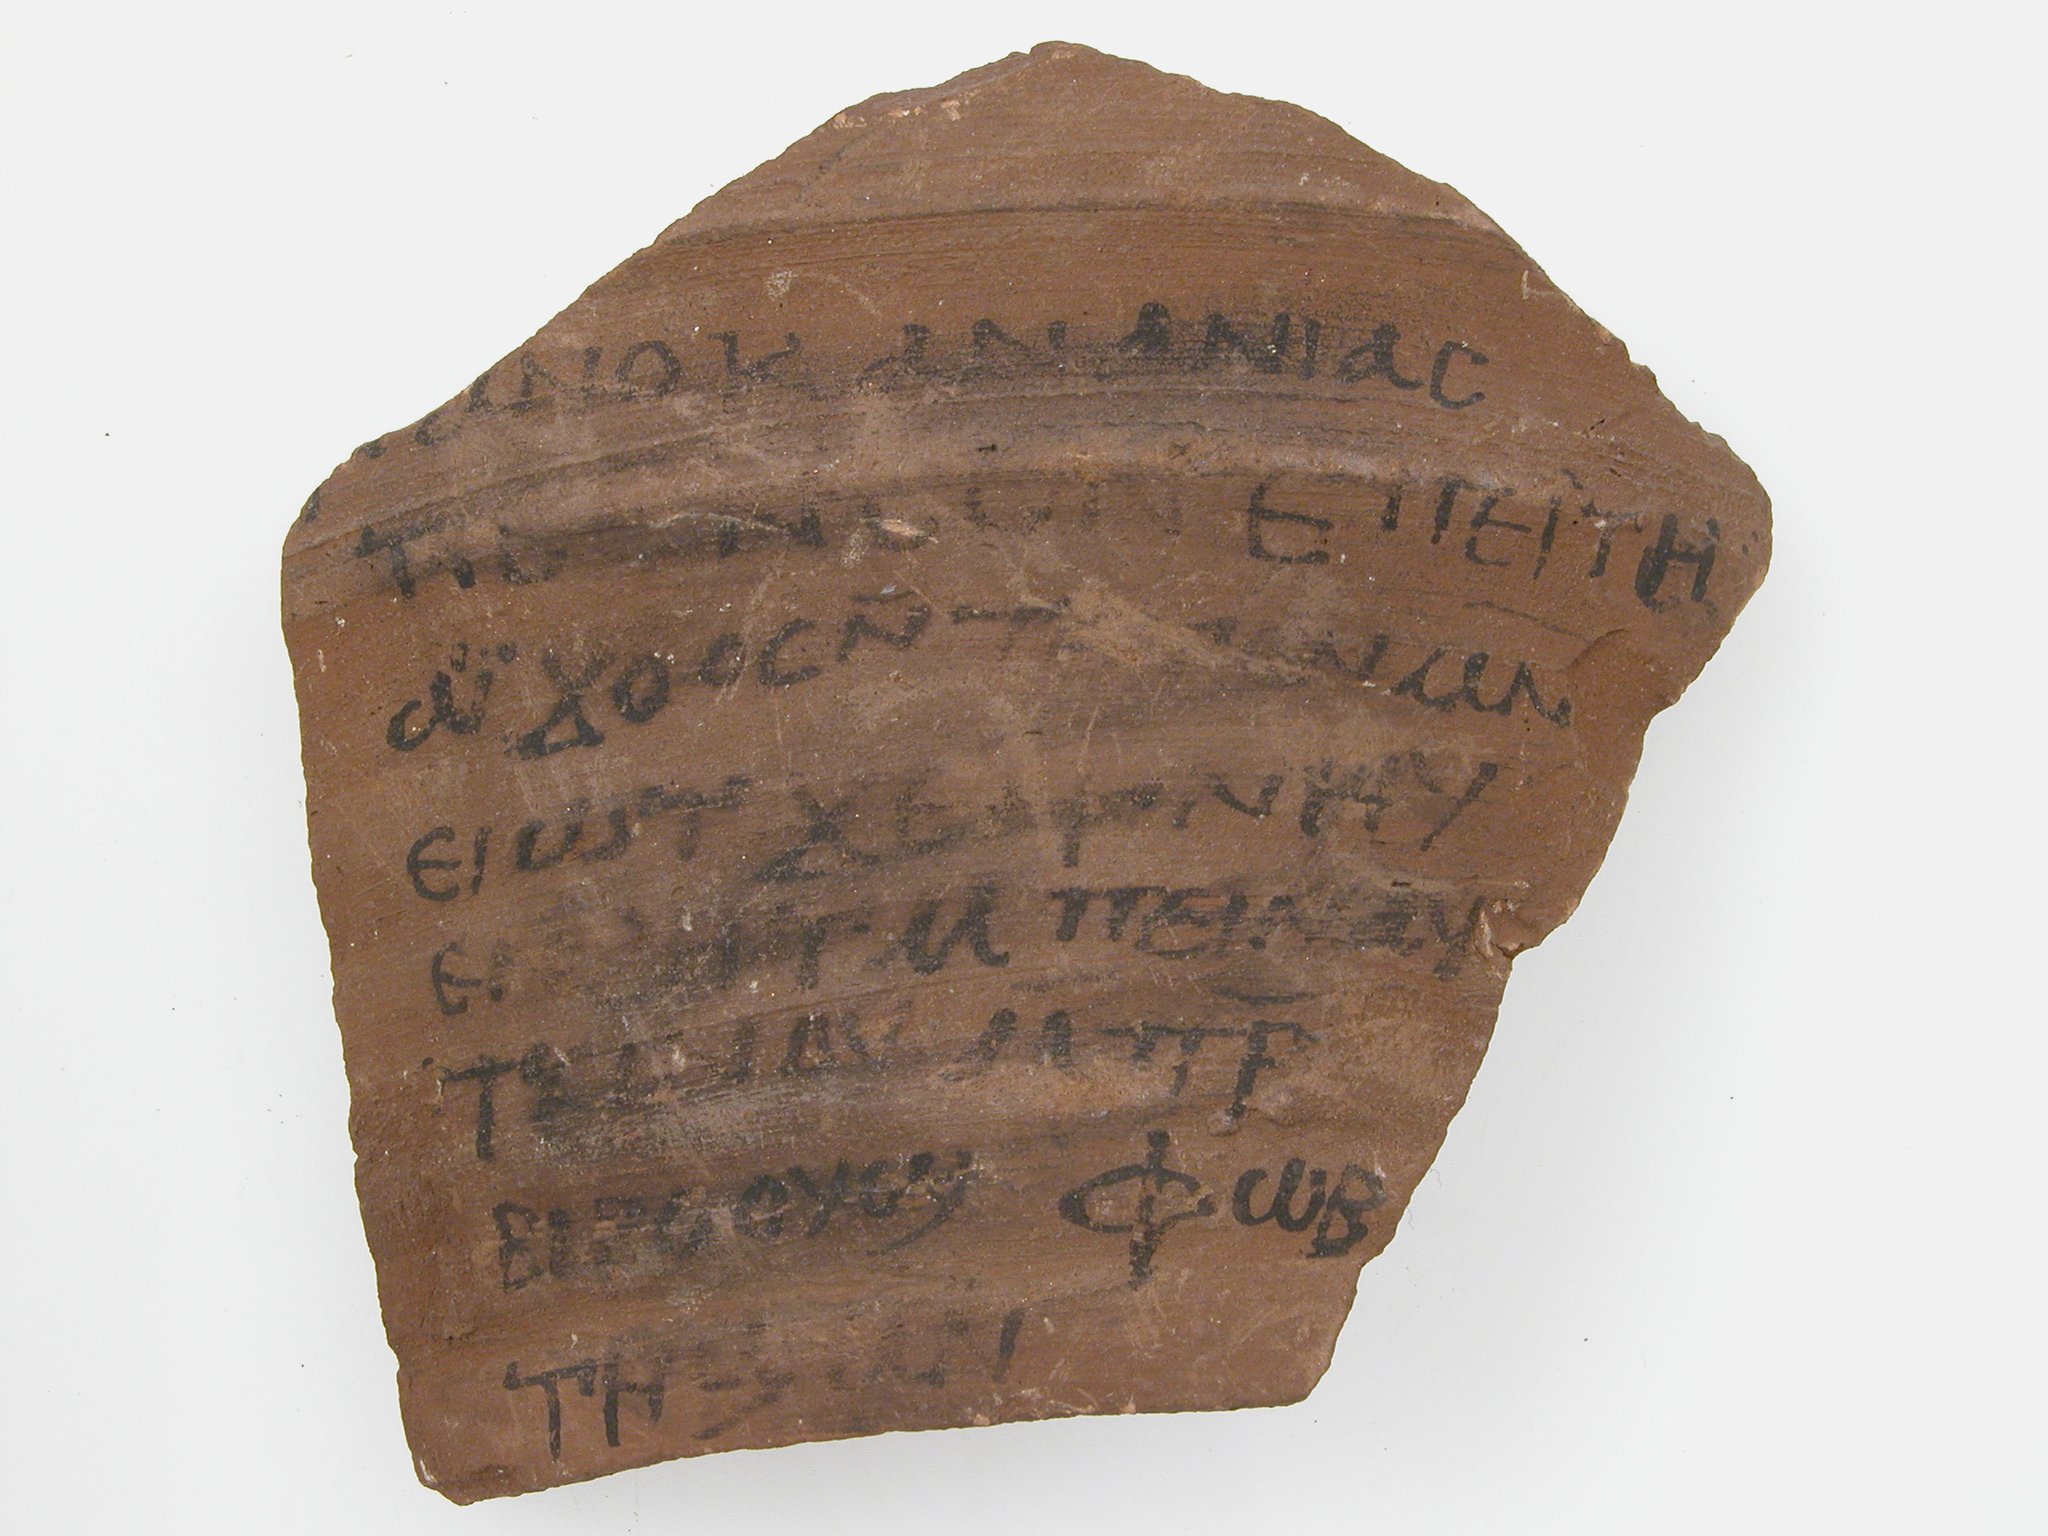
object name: ostrakon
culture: coptic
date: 601-700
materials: ink, pottery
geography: egypt